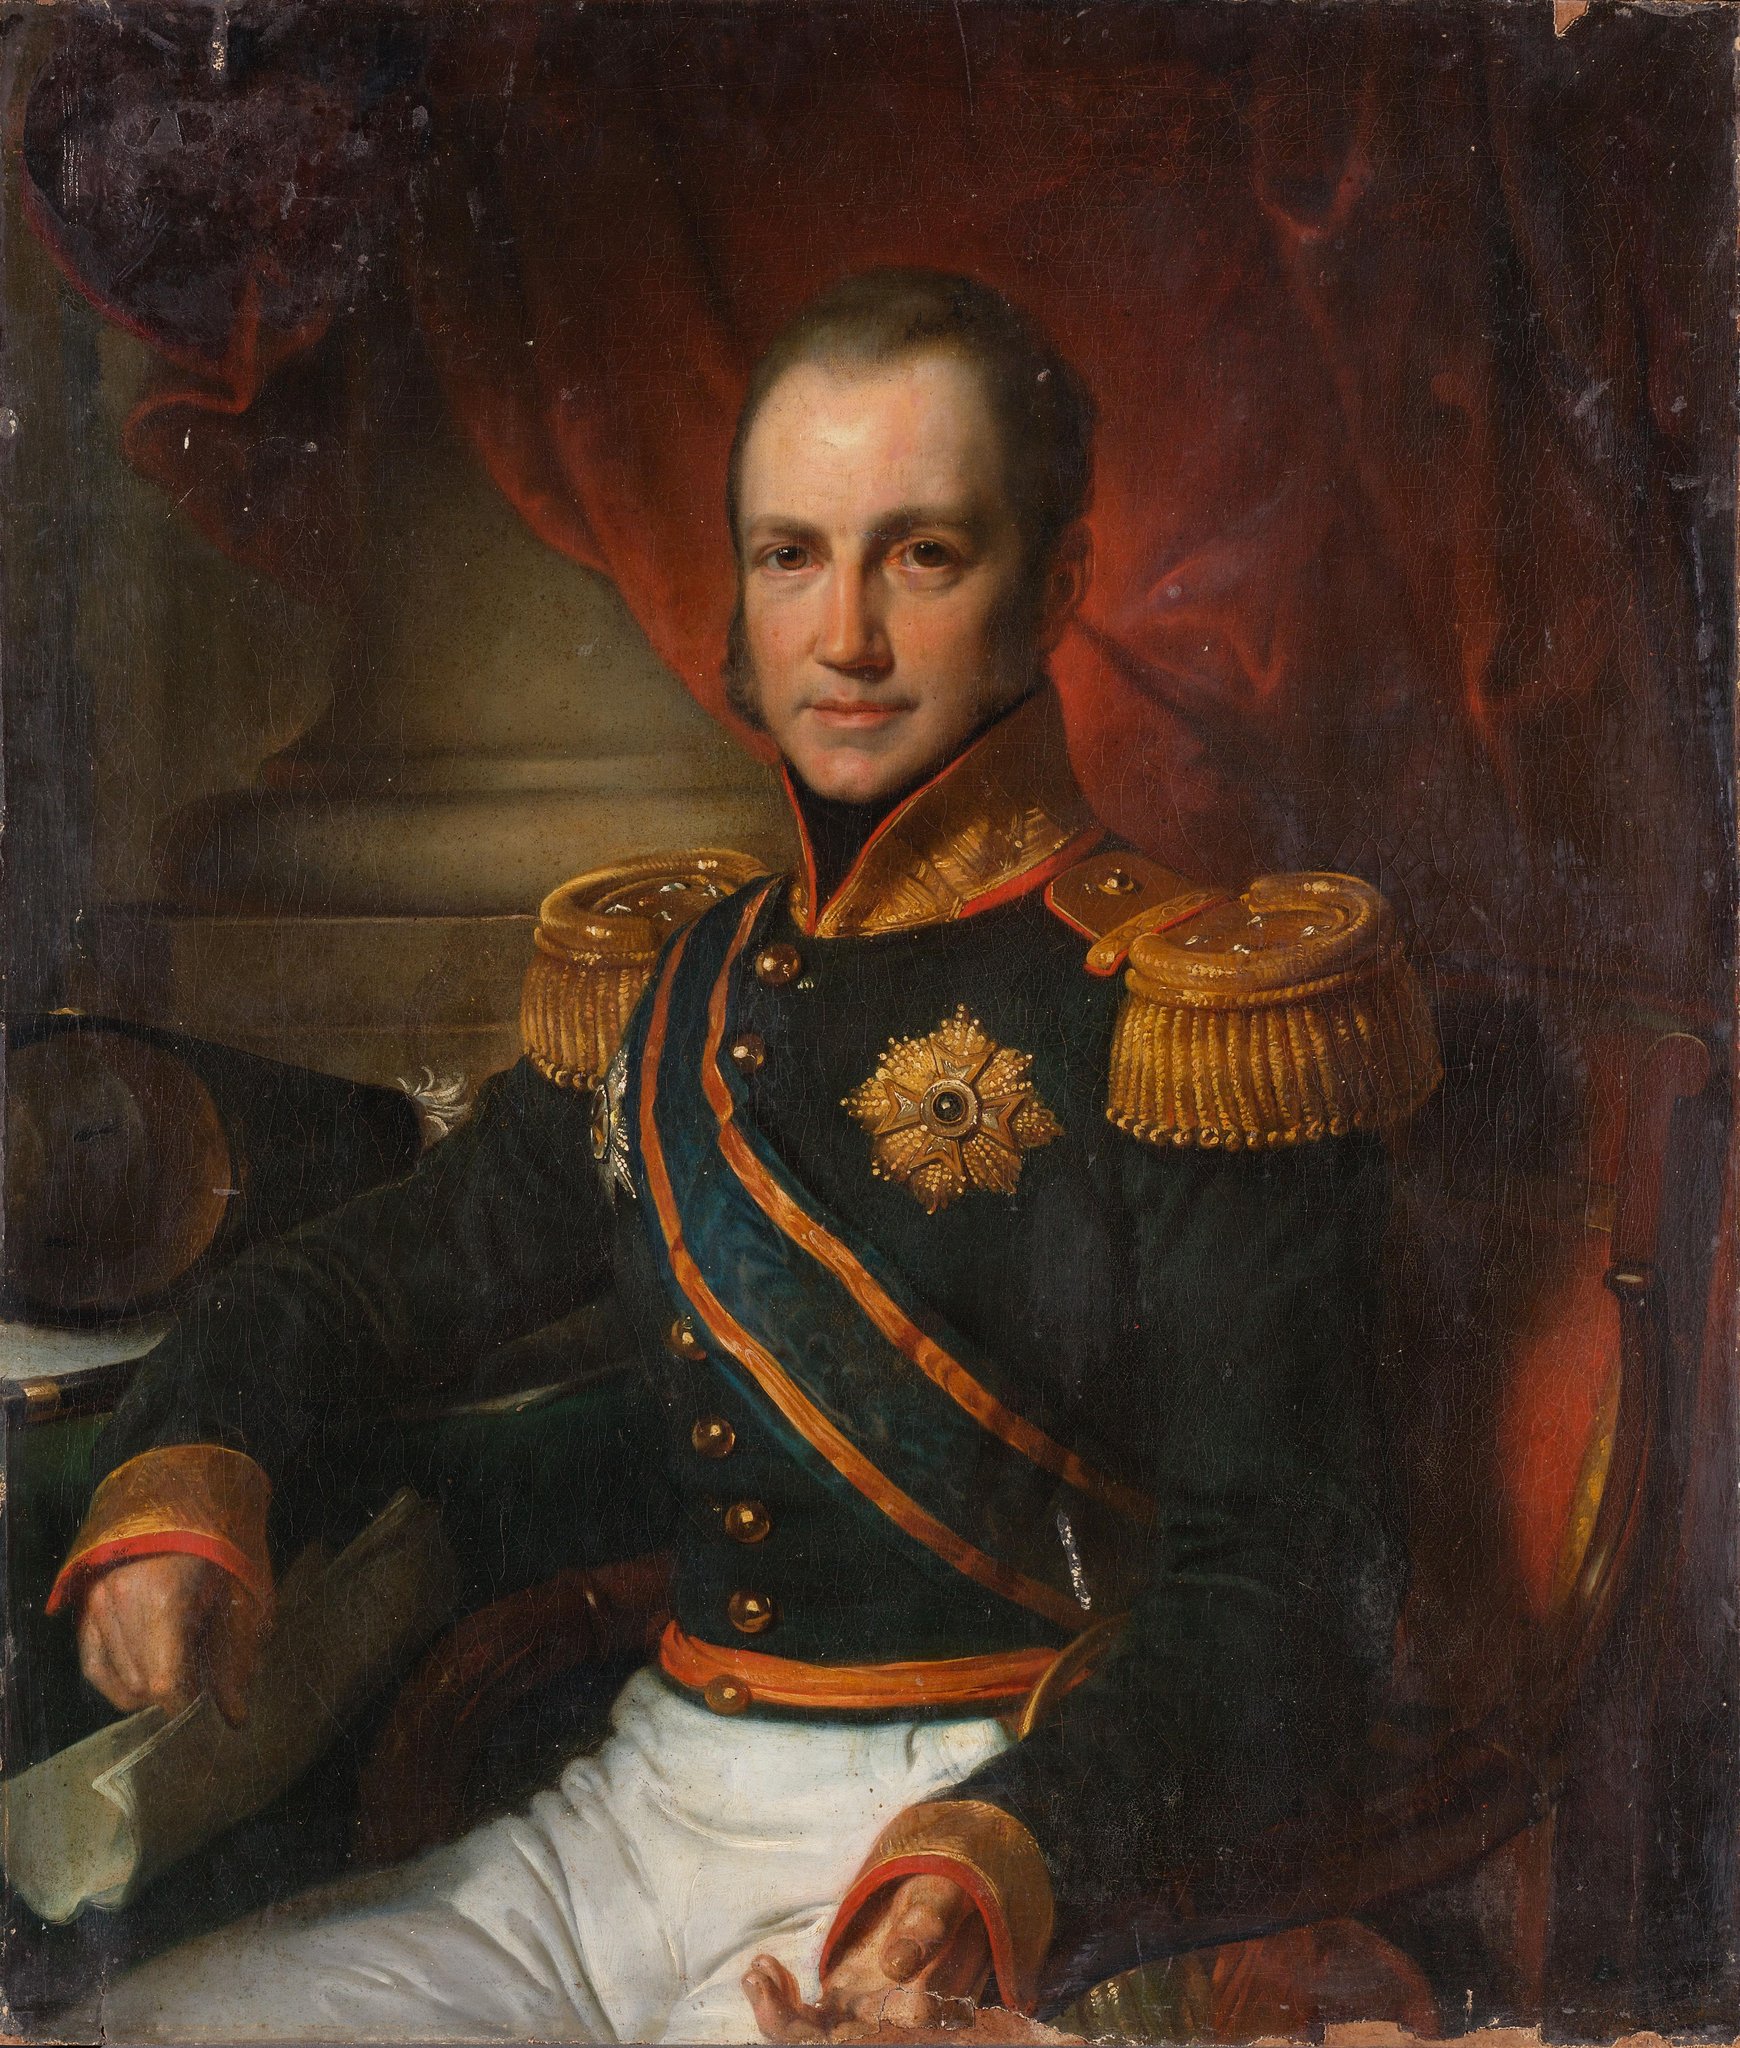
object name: painting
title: Portrait of Godart Alexander Gerard Philip, Baron van der Capellen, Governor-General of the Dutch East Indies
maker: cornelis kruseman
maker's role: draughtsman, painter, print maker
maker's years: 1797-1857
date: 1816-1857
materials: canvas, board, oil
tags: godert alexander gerard philip capellen, colonial governor, historical persons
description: Portret van Godart Alexander Gerard Philip baron van der Capellen (1778-1848). Gouverneur-generaal (1816-26). Ten halven lijve, zittend in een stoel. In de document in de rechterhand, gebarend met de linkerhand. Links een tafel waarop een commandostaf en een steek. Onderdeel van een reeks van portretten van de gouverneurs-generaal van het voormalige Nederlands Oost-Indië.